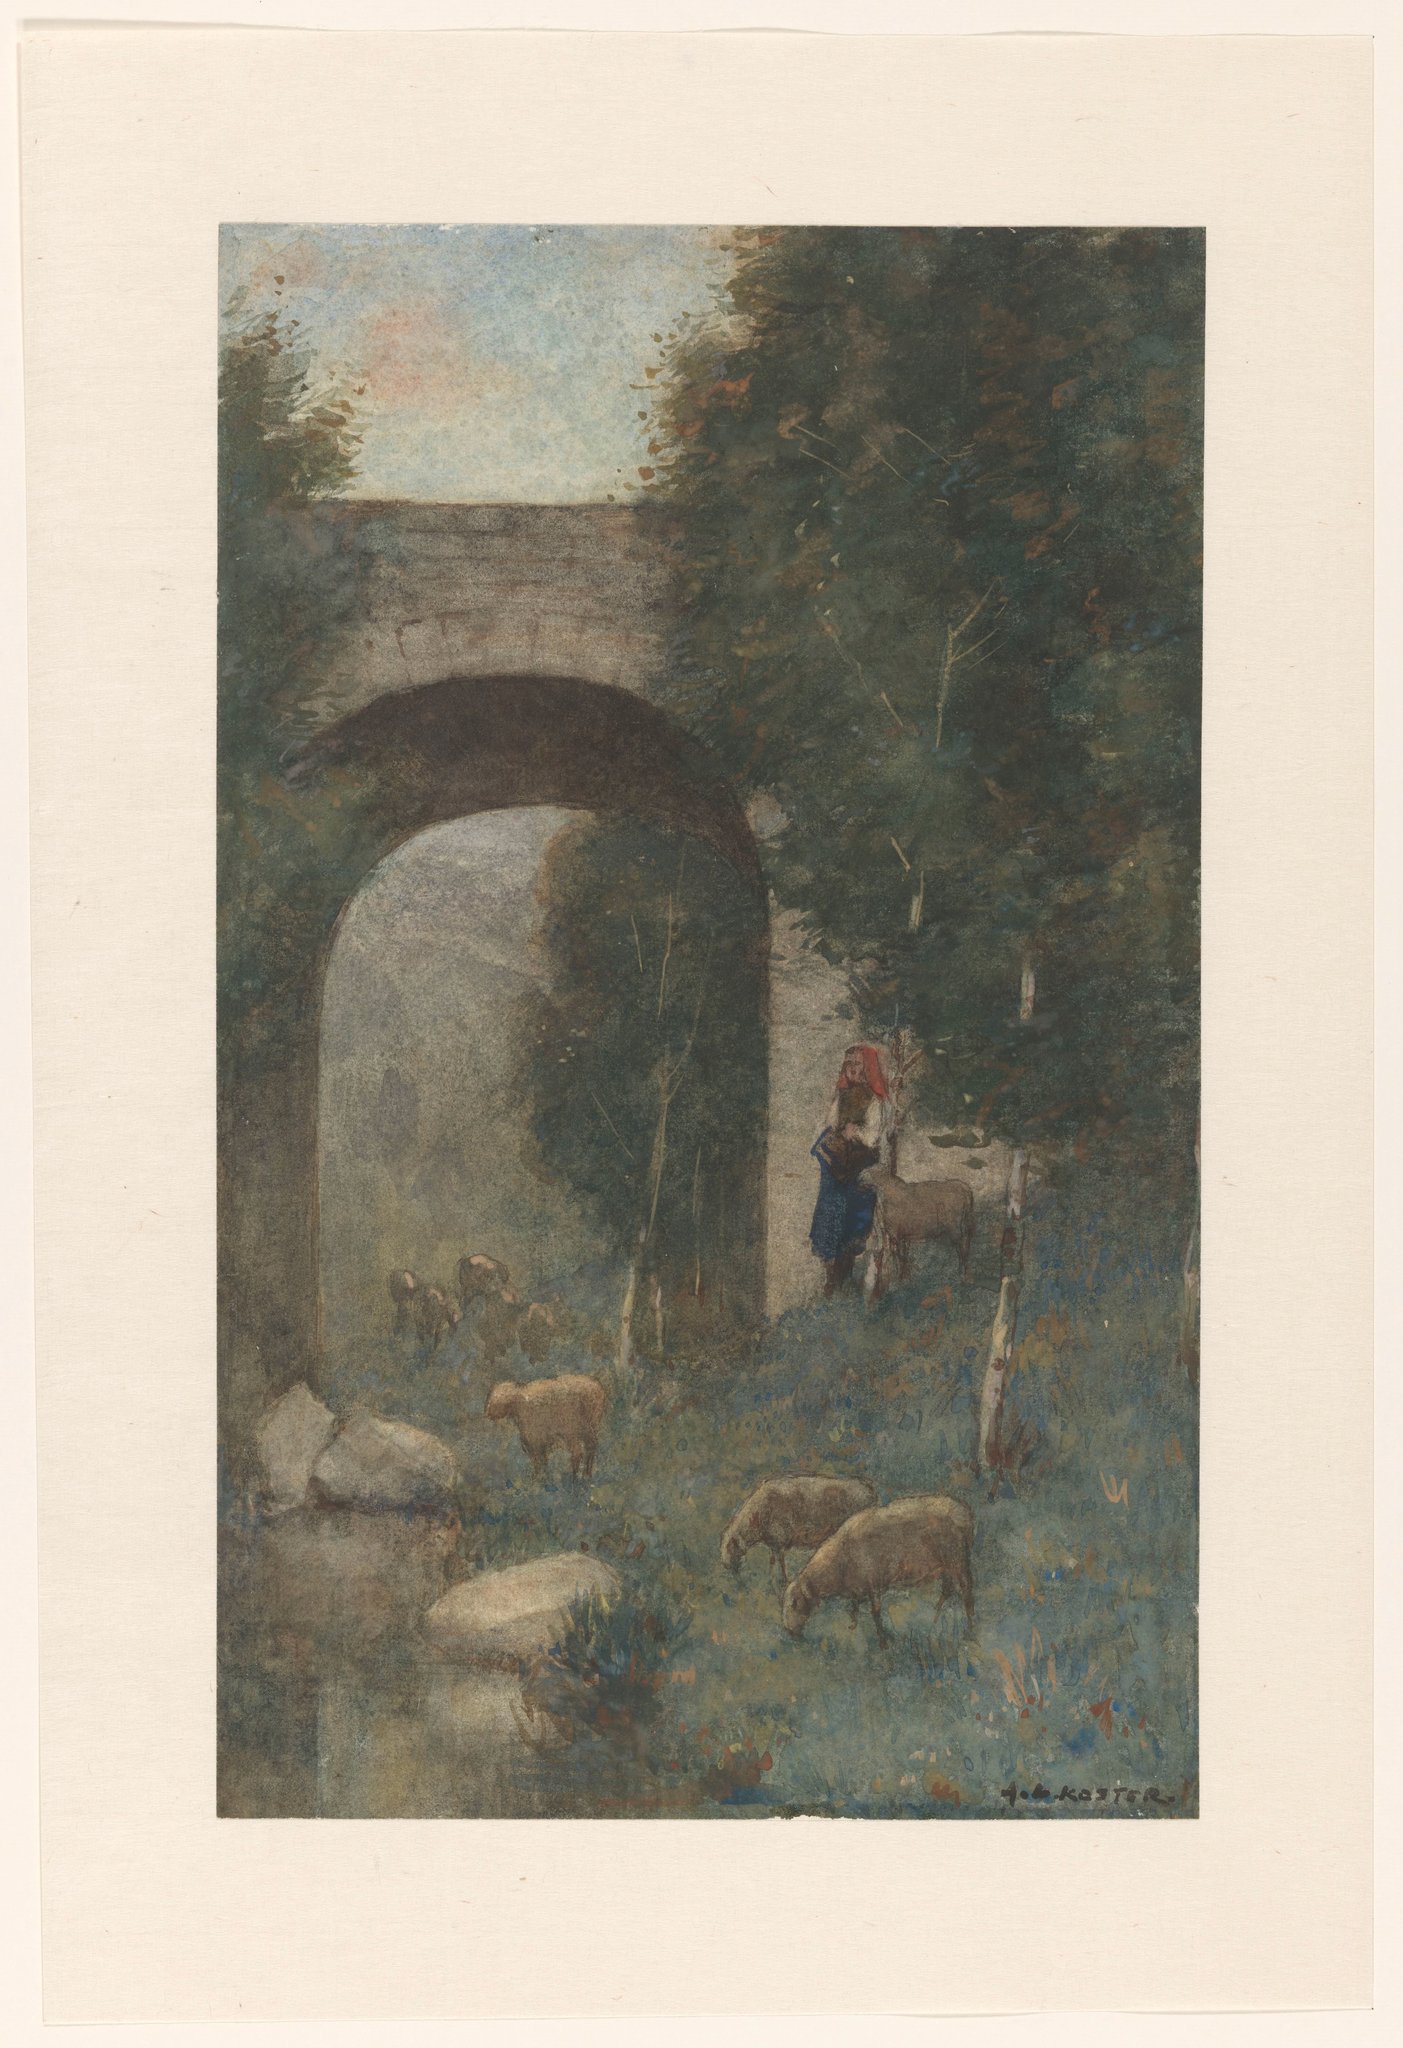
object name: watercolor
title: Herderin met schapen, bij een viaduct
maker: anton l. koster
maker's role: draughtsman, painter, print maker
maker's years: 1859-1937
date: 1869-1937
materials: chalk, paper, watercolor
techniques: brush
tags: landscape with bridge, viaduct or aqueduct, sheep, herd, flock